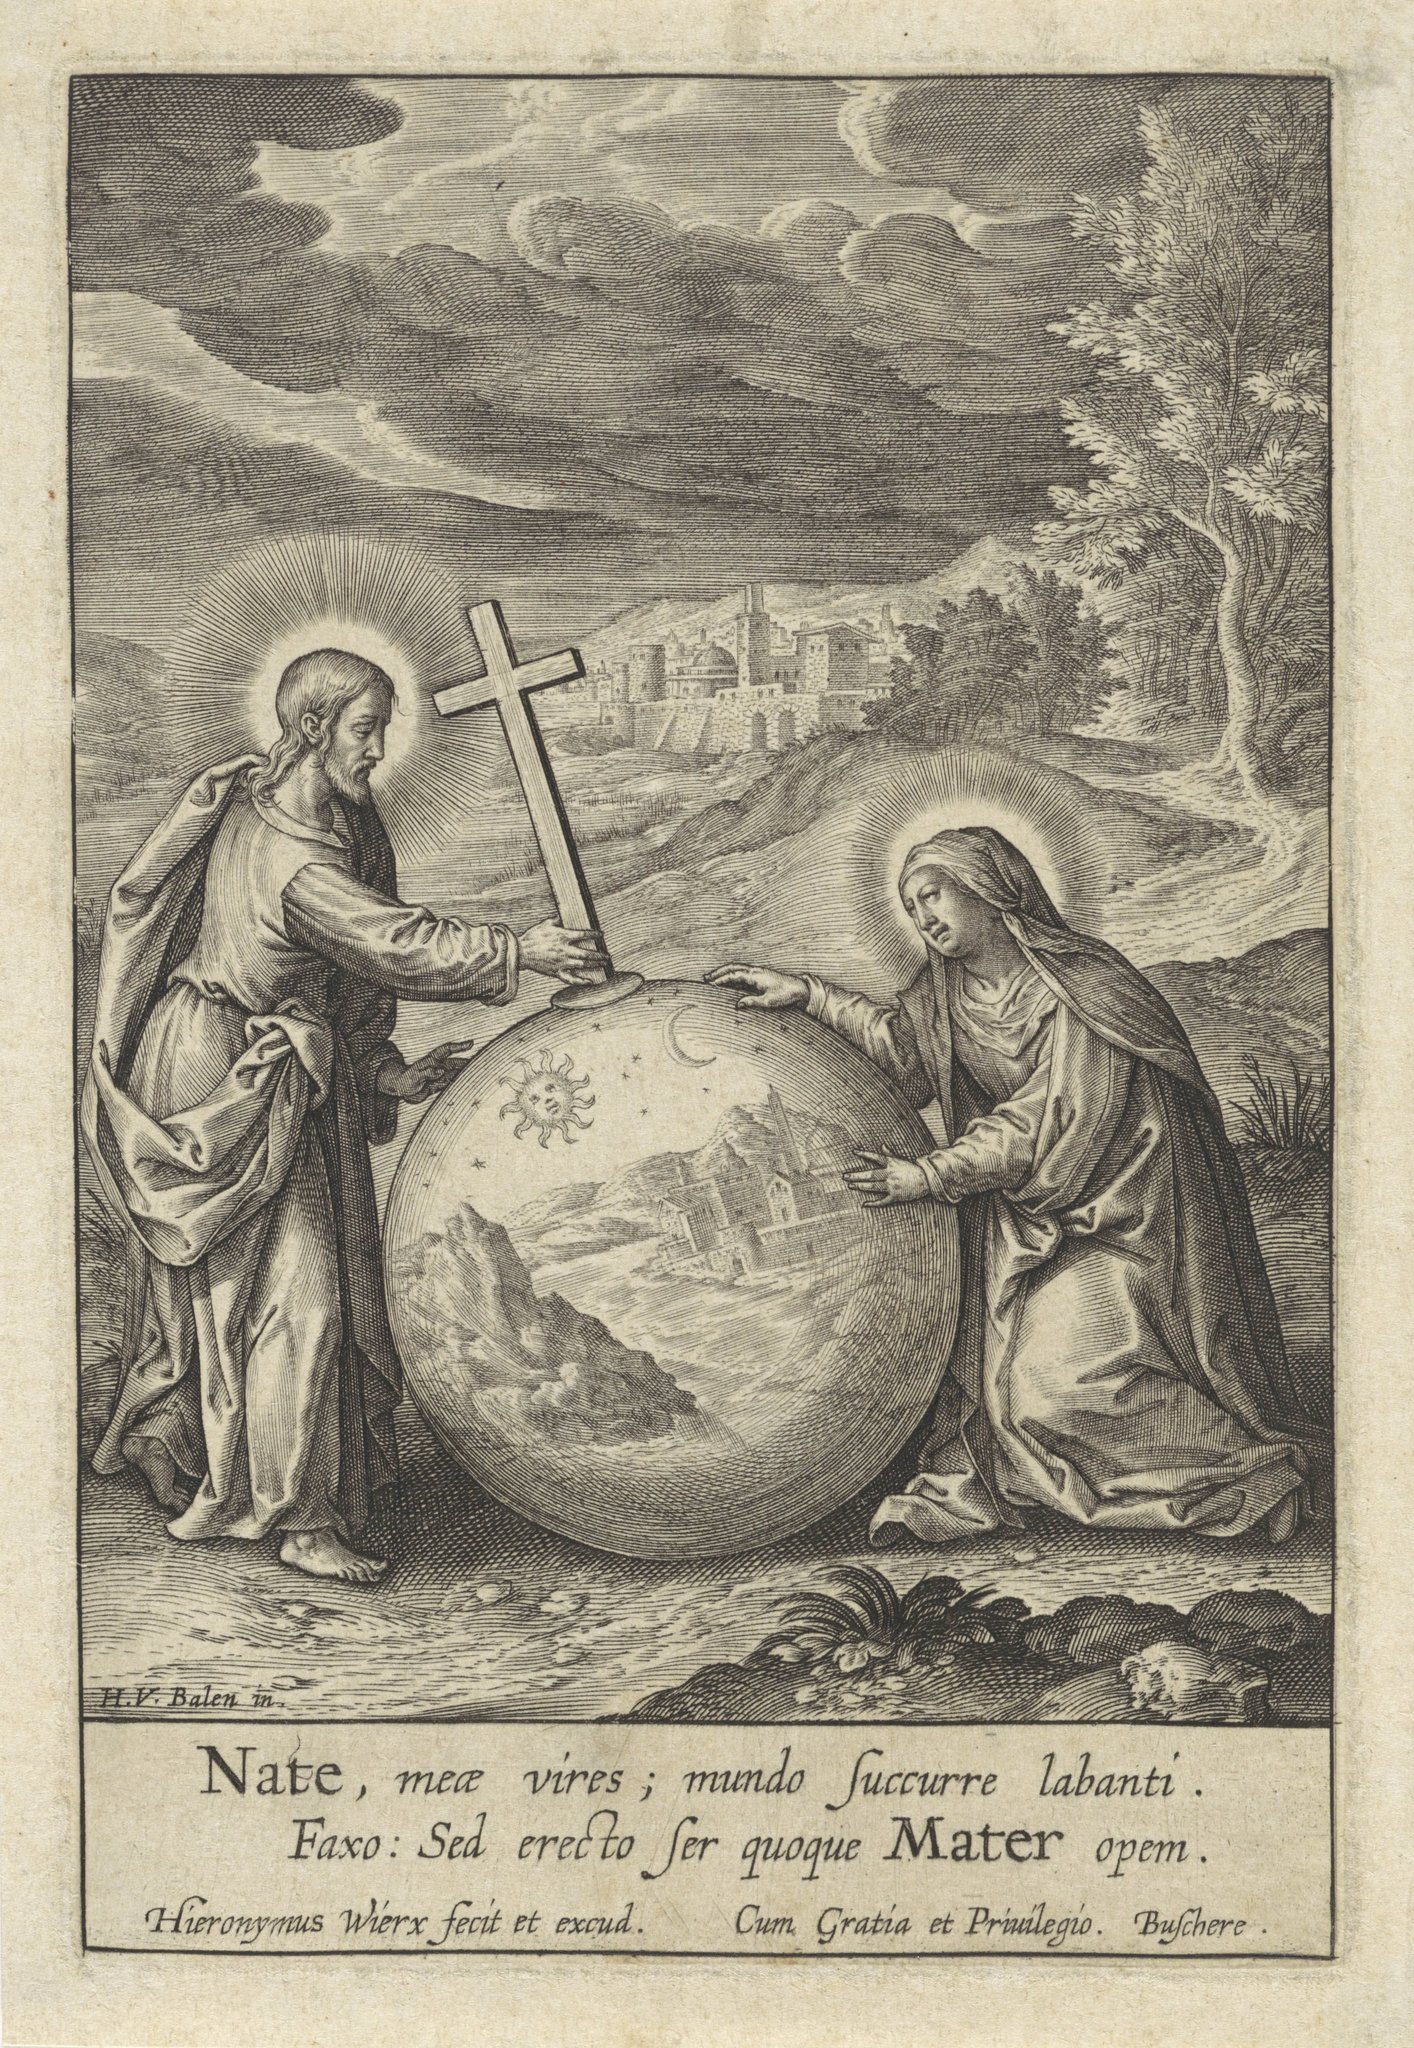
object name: print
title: Christus en Maria bij een rijksappel in een landschap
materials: paper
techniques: engraving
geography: antwerp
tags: mary (without the christ-child), 'salvator mundi', making a blessing gesture; an orb in his hand or at his feet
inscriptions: collector's mark: Lugt 2228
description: Landschap met Christus als Salvator Mundi en de maagd Maria bij een grote rijksappel waarop de stad Jeruzalem is afgebeeld. Christus reikt met zijn hand naar zijn moeder. In de marge een tweeregelig onderschrift in het Latijn.